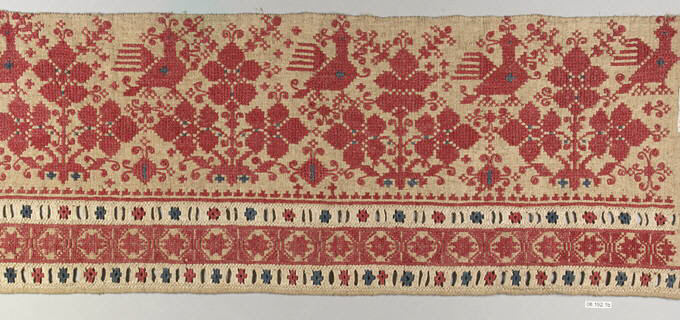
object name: sleeve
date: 1767-1833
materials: cotton, linen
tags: birds,flowers